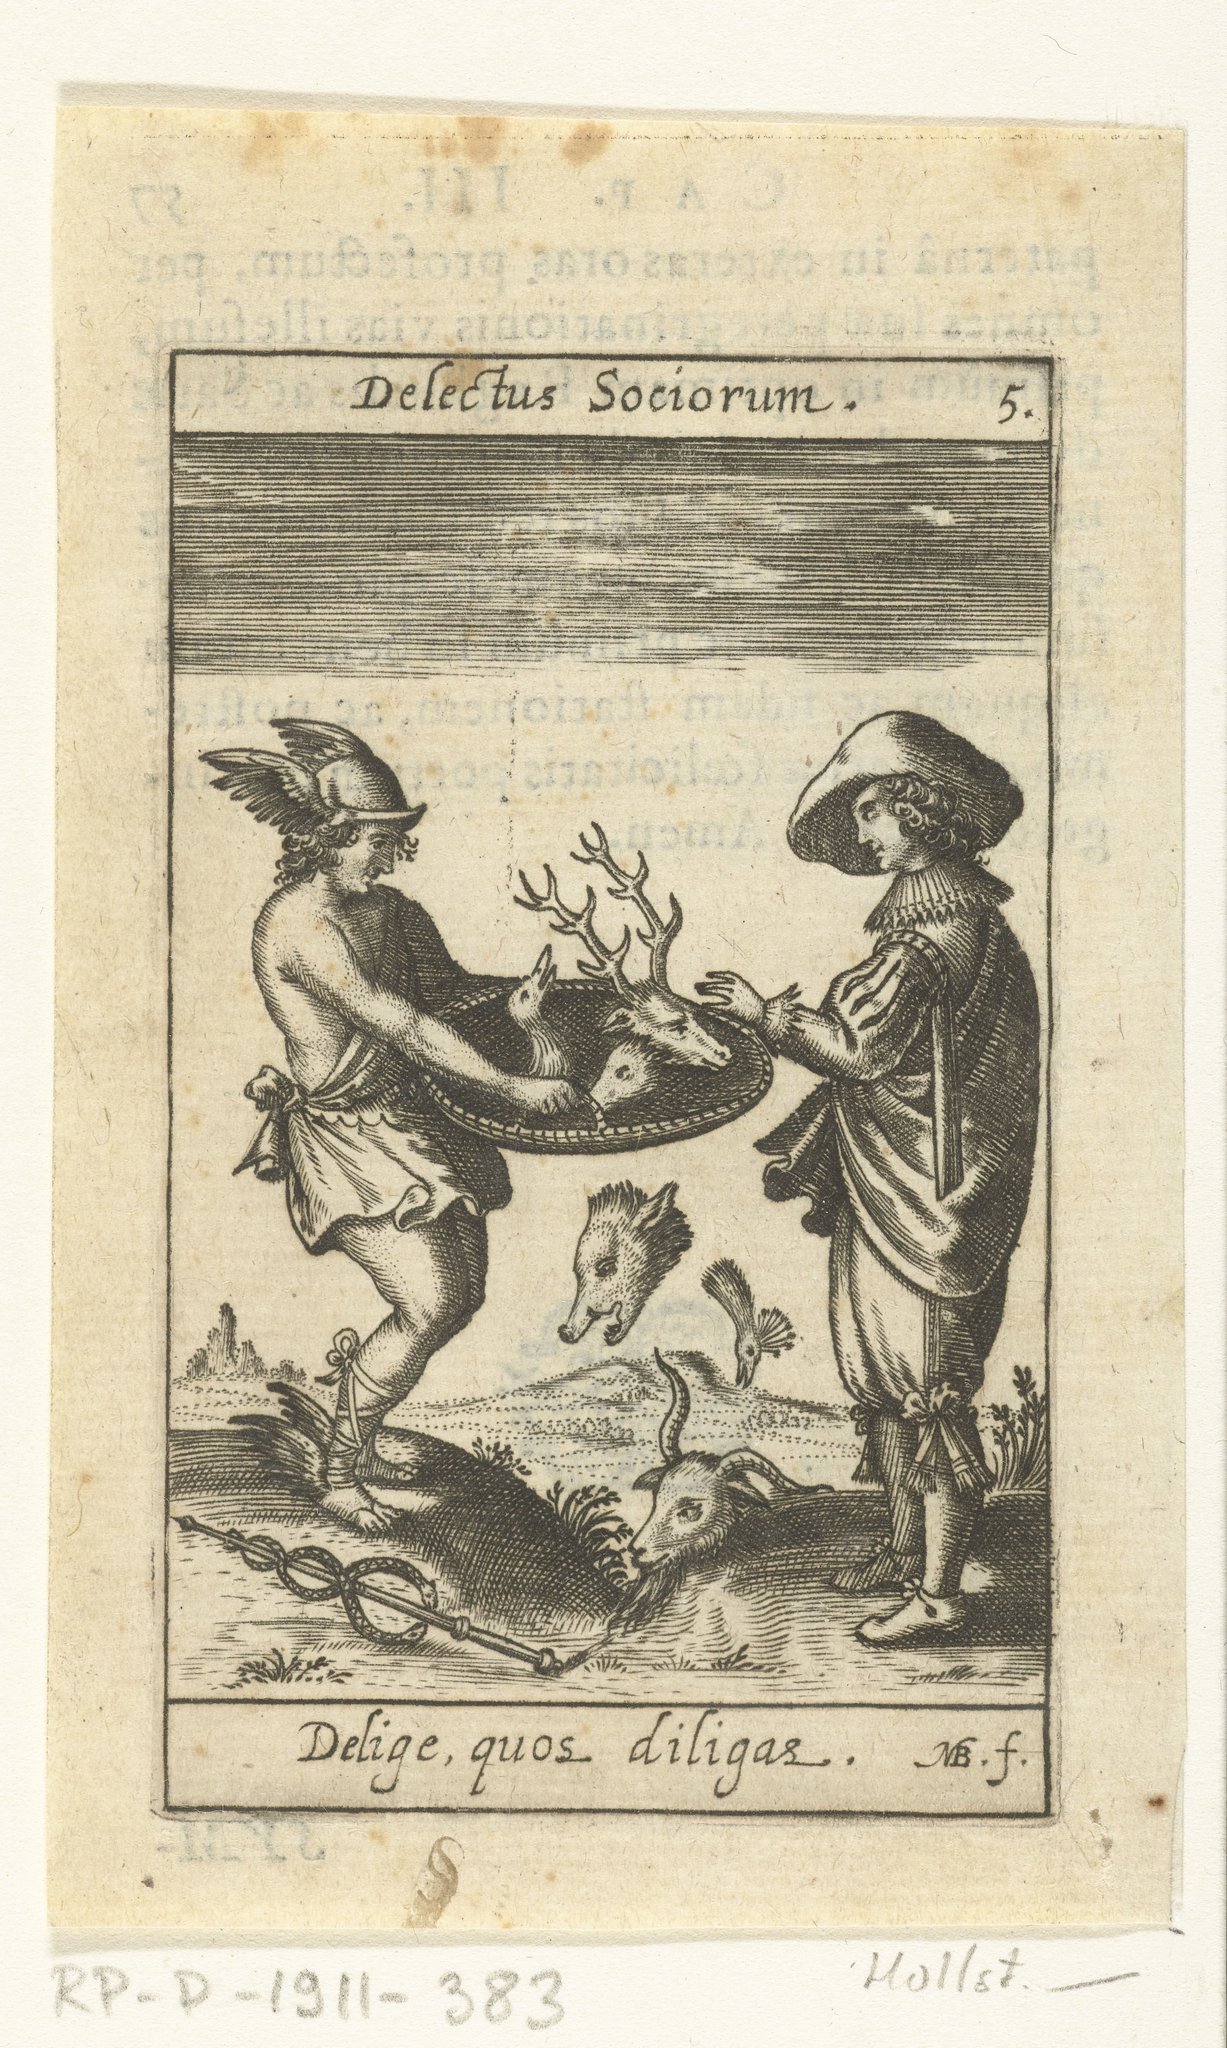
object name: print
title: Mercurius met een schaal afgehakte koppen van dieren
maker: martin baes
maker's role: print maker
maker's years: 1604-1637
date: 1614-1631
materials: paper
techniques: engraving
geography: douai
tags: (story of) mercury (hermes)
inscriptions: collector's mark: Lugt 2228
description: Mercurius biedt een edelman een schaal met afgehakte dierhoofden aan. Het gaat om hoofden van een eend, pauw, zwijn, bok en hert. Onder de voorstelling het motto: Delige, quos diligas. Bladzijde uit een embleemboek, aan de versokant tekst in het Latijn.